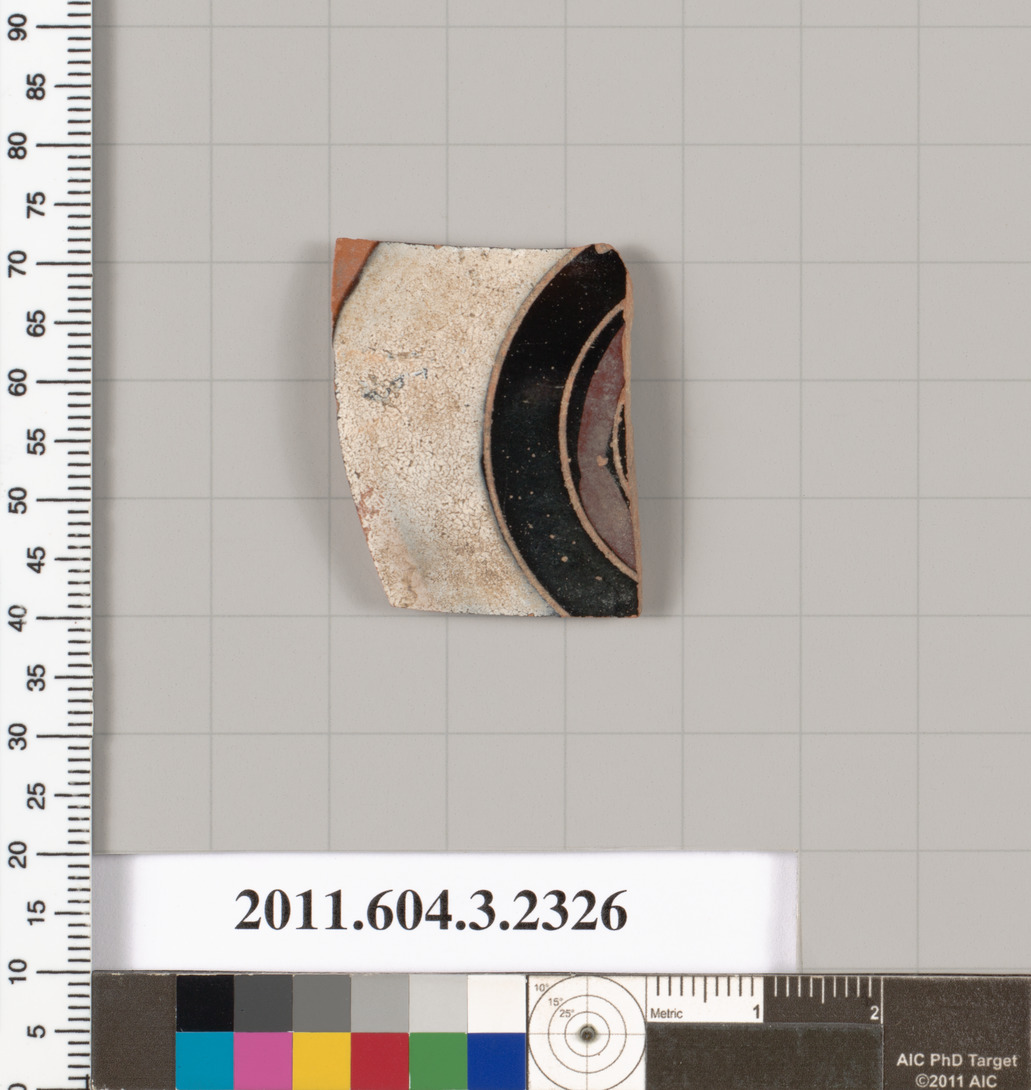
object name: kylix fragment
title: Terracotta fragment of a kylix: eye-cup (drinking cup)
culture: greek, attic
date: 540-520 BCE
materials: terracotta